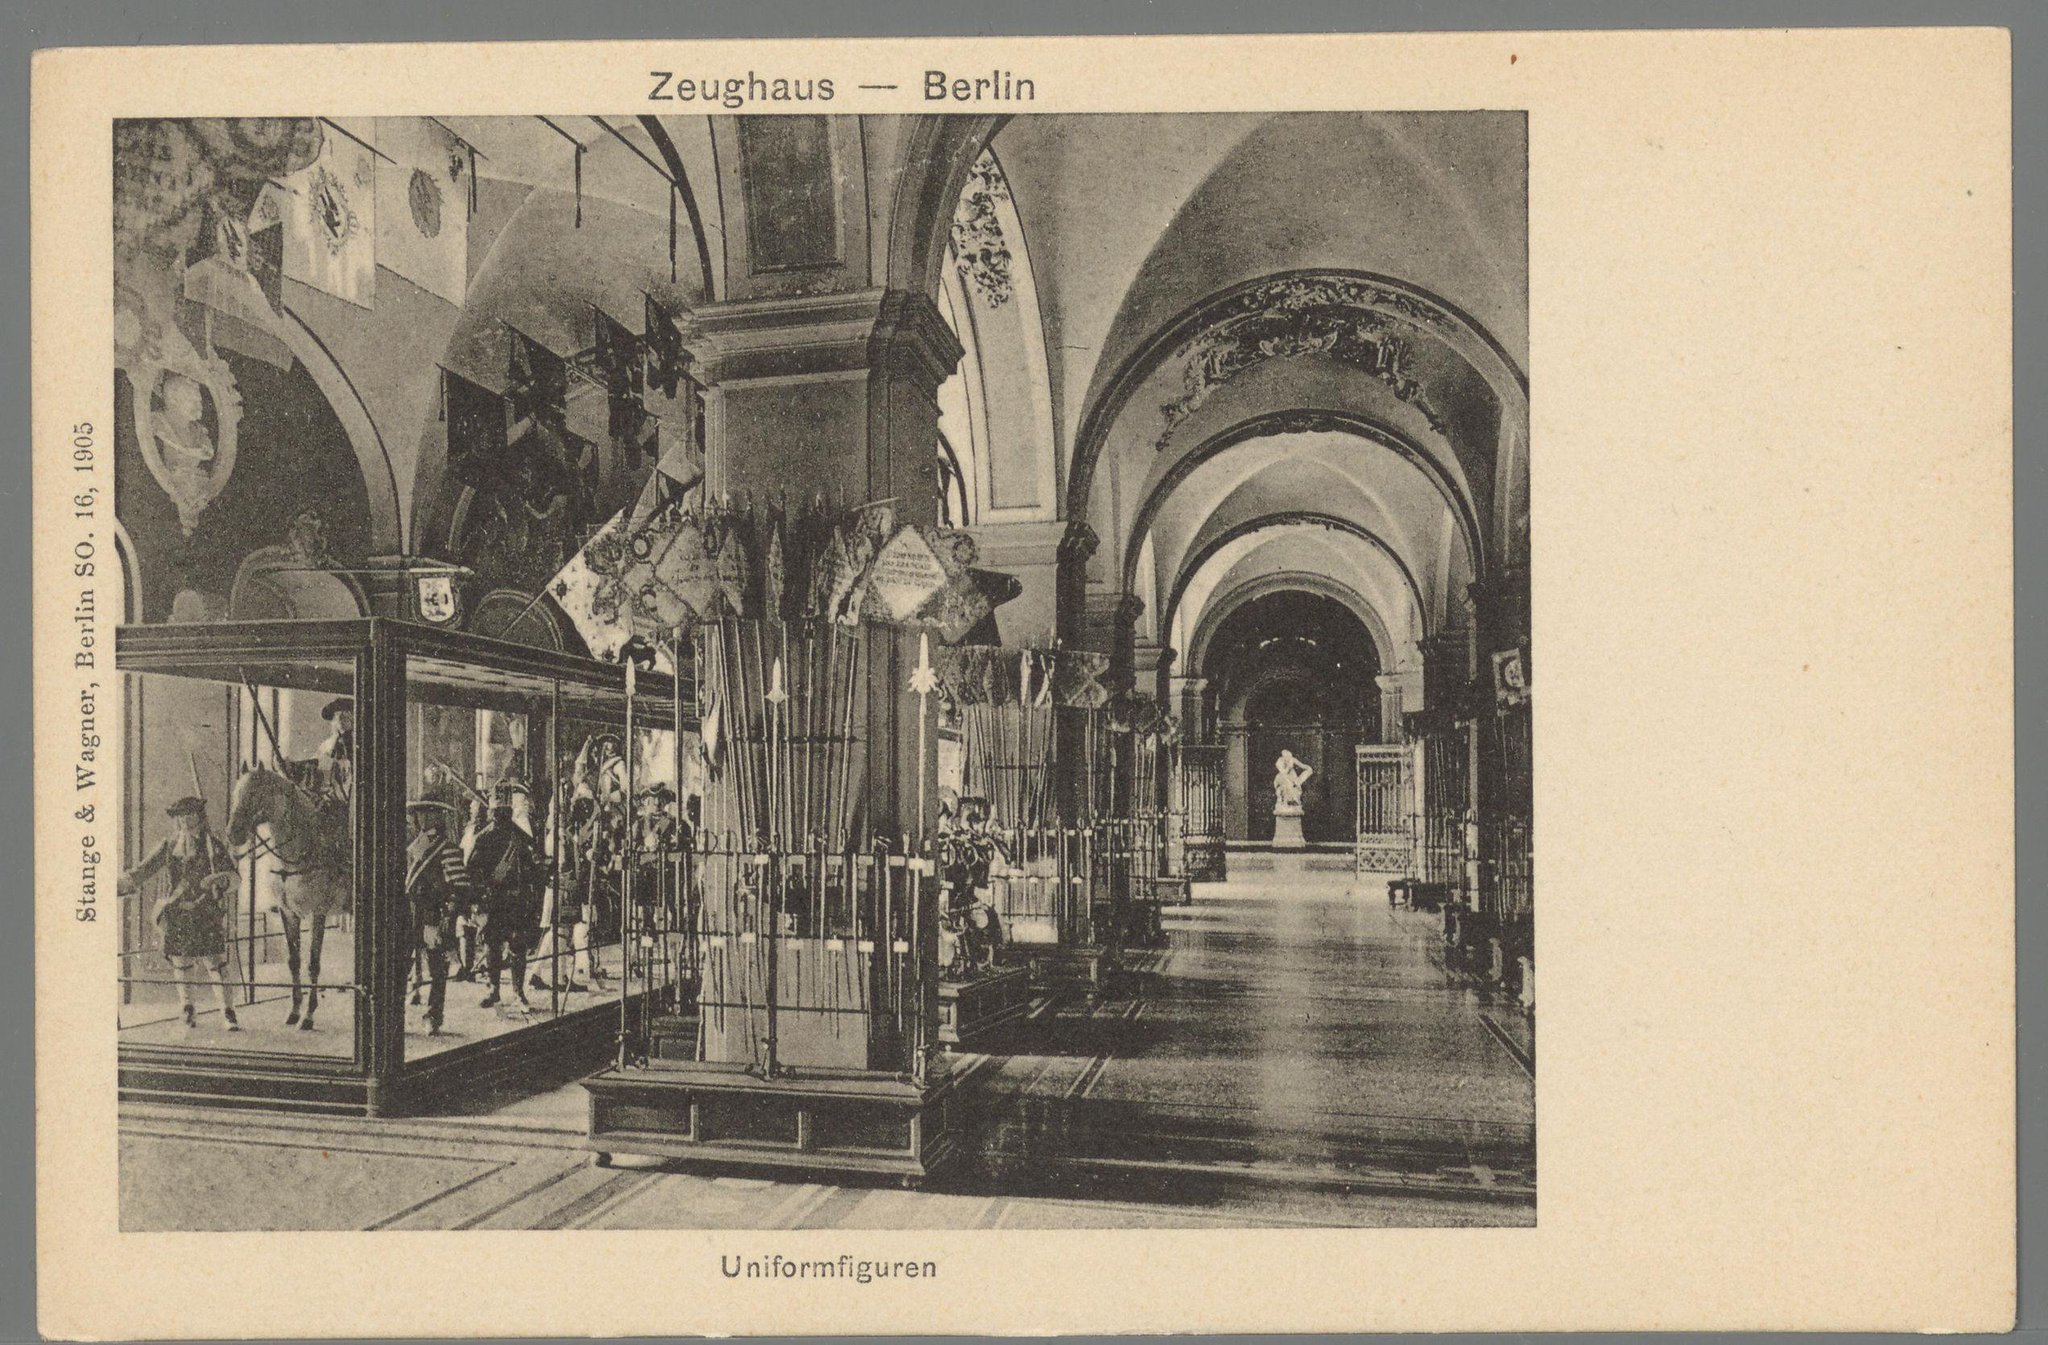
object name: ansichtkaart, prentbriefkaart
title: Zeughaus - Berlin. Uniformfiguren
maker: Anonymous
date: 1905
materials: cardboard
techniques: photograph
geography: berlin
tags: permanent exhibition, museum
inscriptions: date